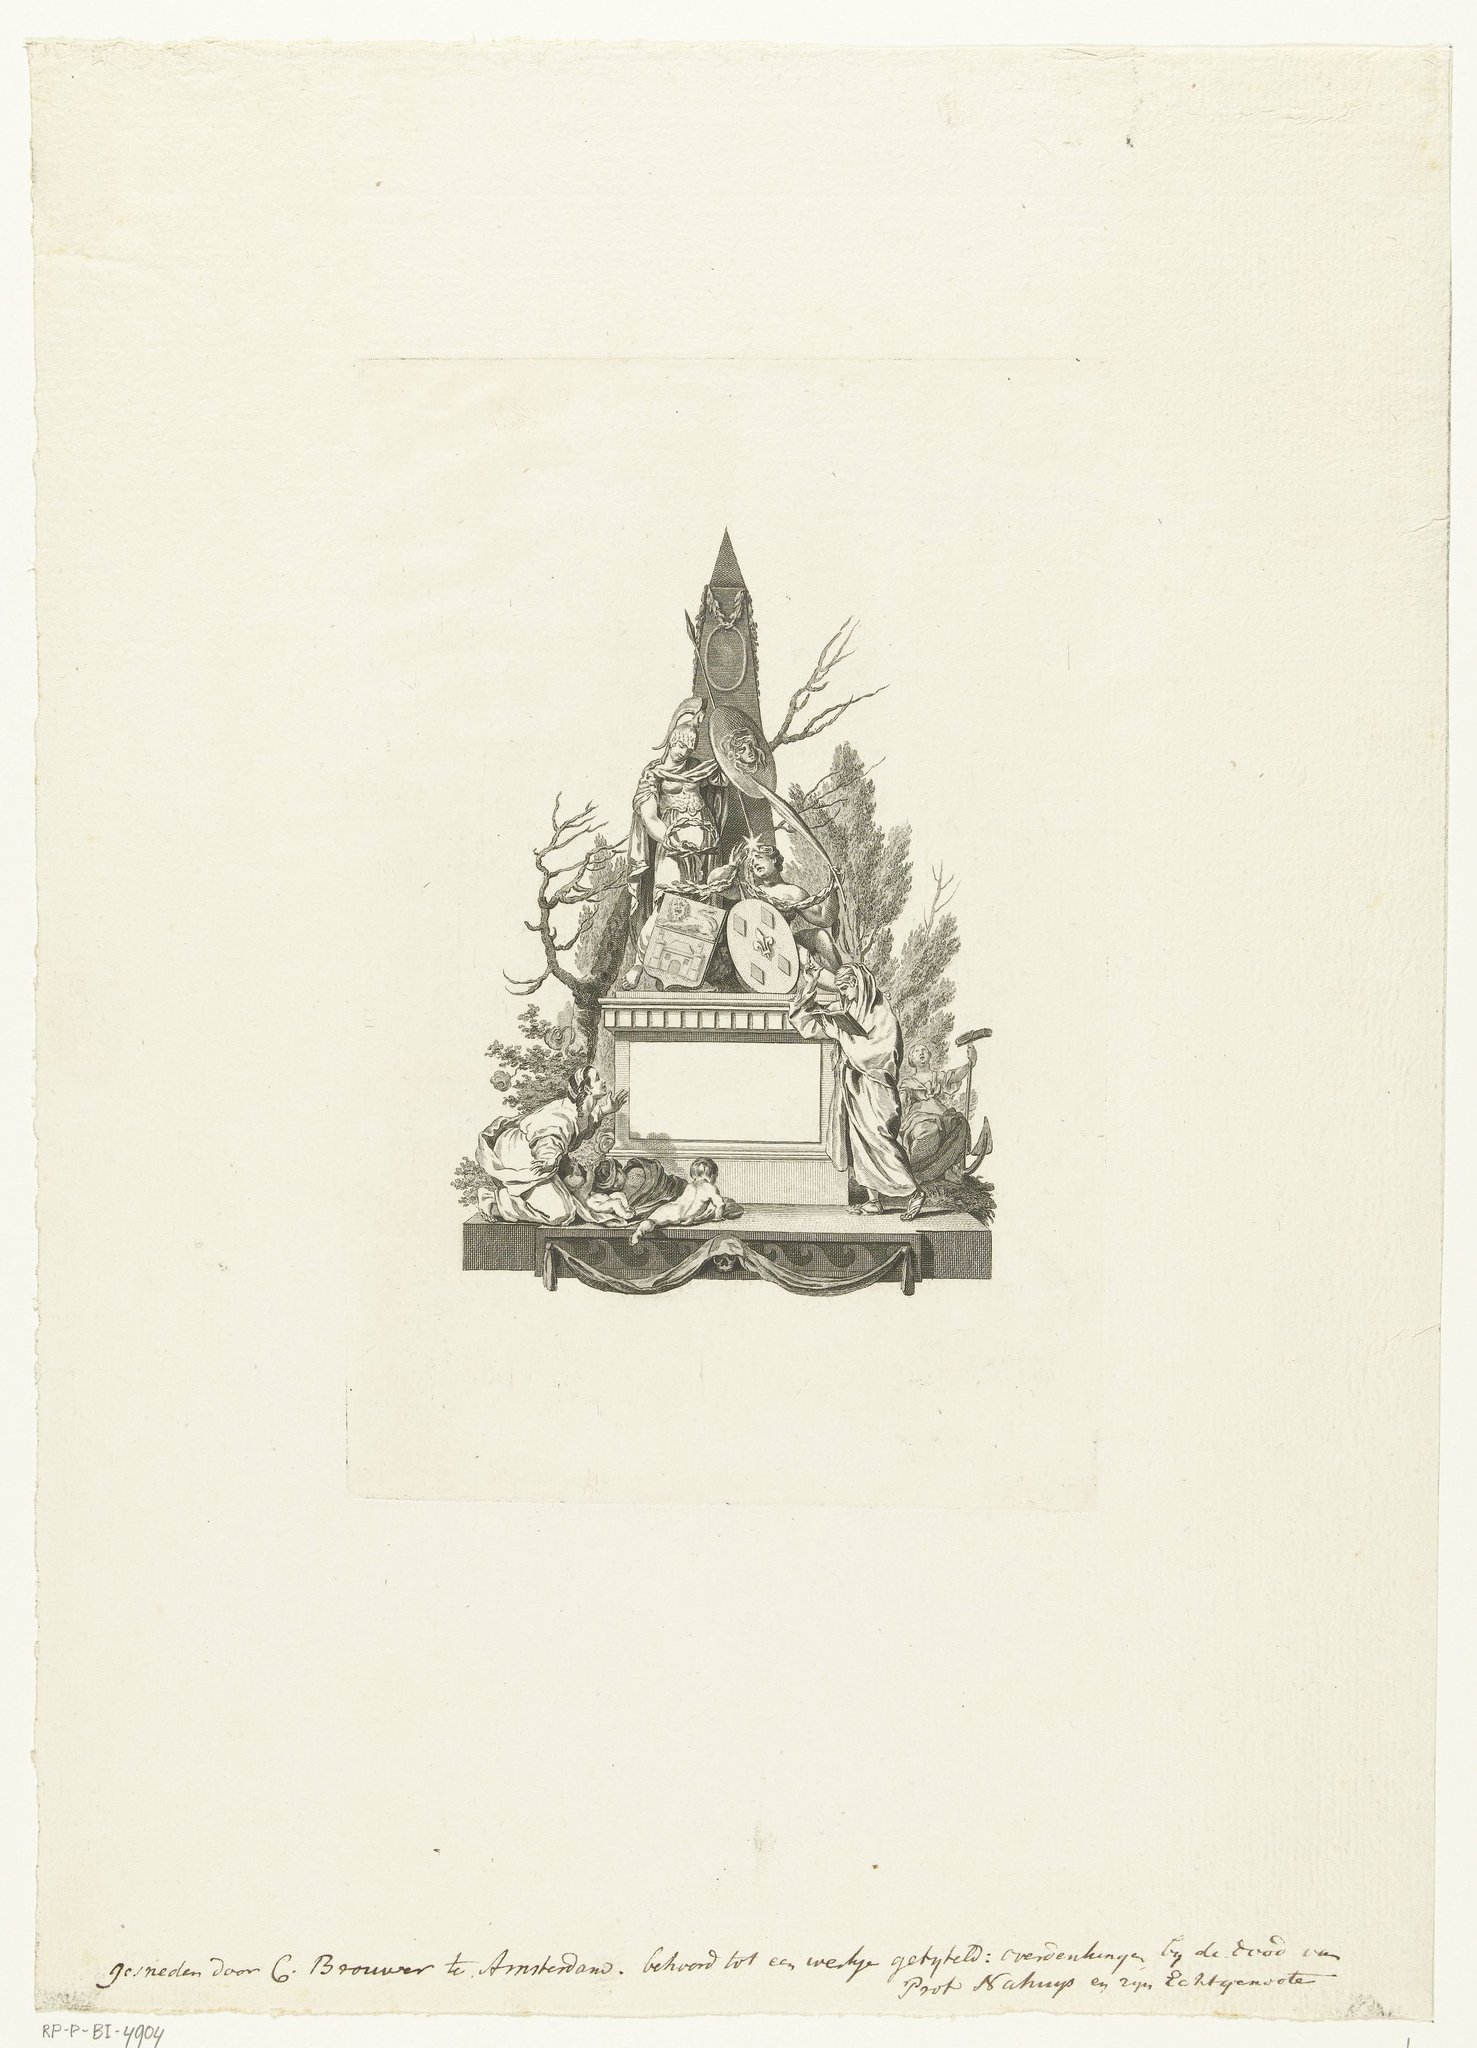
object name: print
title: Allegorisch gedenkteken voor Gerard Johan Nahuys en zijn echtgenote Catharina Walburg van Mansvelt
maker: cornelis brouwer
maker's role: print maker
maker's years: 1731-1803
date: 1782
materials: paper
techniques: etching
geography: netherlands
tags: obelisk, needle, grave, tomb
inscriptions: collector's mark: Lugt 240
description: Prent naar tekening van Pieter Wagenaar (II). Prent gebruikt voor uitgave met overdenkingen bij de dood van Gerard Johan Nahuys en zijn echtgenote Catharina Walburg van Mansvelt aldus opschrift op recto. Na de dood van het echtpaar verschenen diverse uitgaven, het is onduidelijk om welke publicatie het gaat. Vergelijk een exemplaar in de collectie van de UB in Amsterdam waarin de namen van het echtpaar volledig genoemd worden: Johannes Christiaan Mohr, Overdenkingen bij gelegenheid van het ontroerend sterven, van (...) Gerard Johan Nahuys, Amsteldam, H. Keyzer, 1782, zie illustratie.